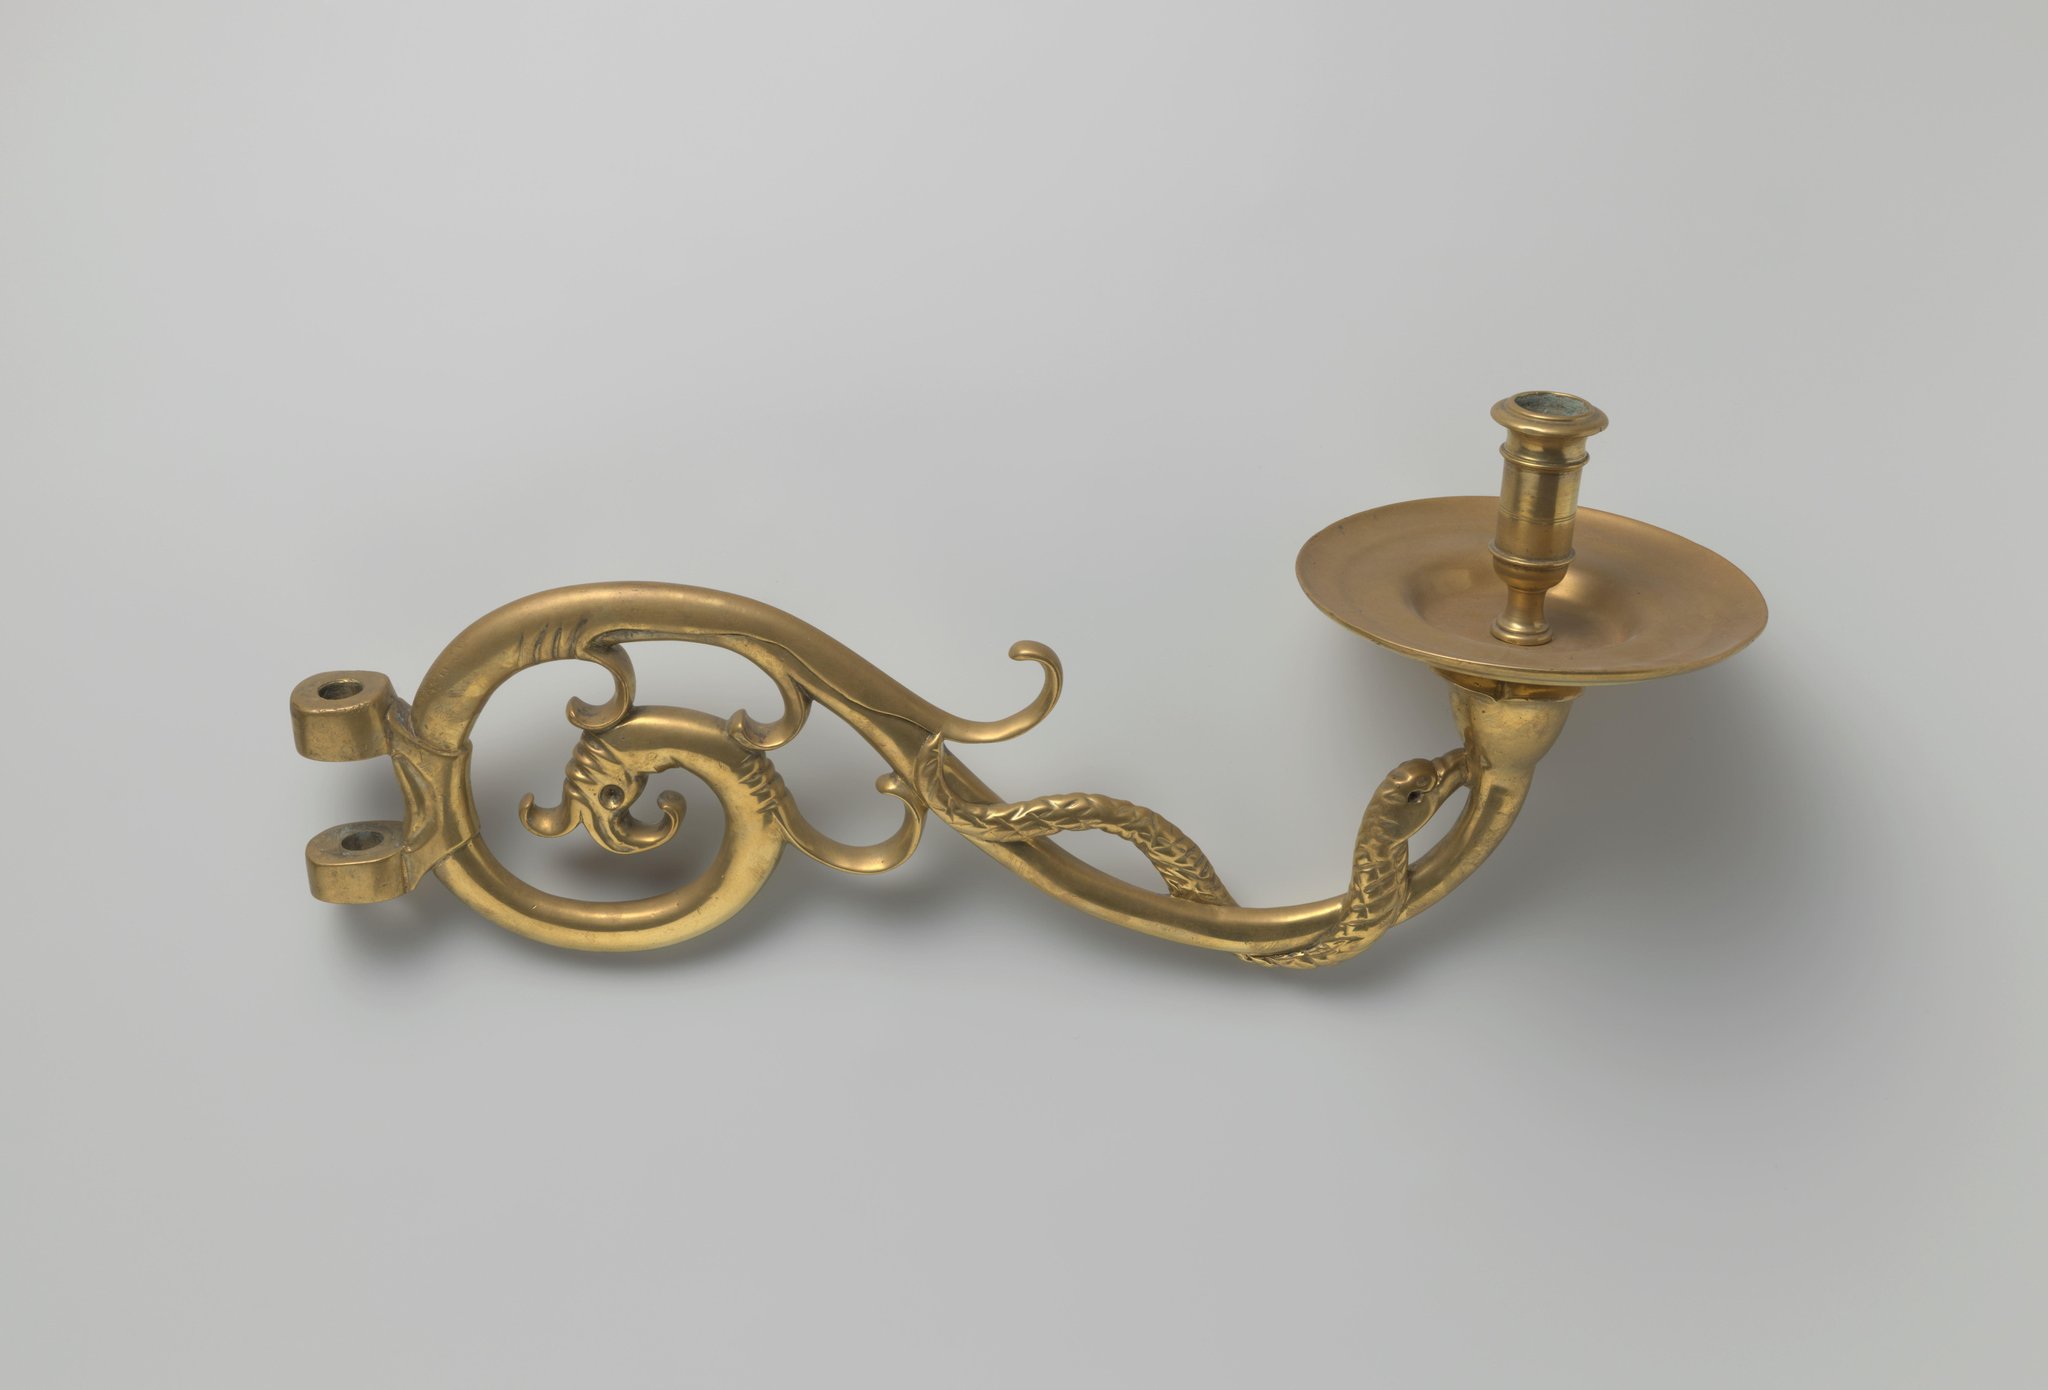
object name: lichtarm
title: Lichtarm met slang en dolfijnenkop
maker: Anonymous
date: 1625-1675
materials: brass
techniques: casting, screwed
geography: netherlands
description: Het voorwerp is in drie delen gegoten: de arm, de vetvanger, de kaarsenhouder. De arm heeft de vorm van een liggende S. Bij het gedeelte, waar de twee ogen zijn aangebracht ter bevestiging aan wand of kansel eindigt hij in een dolfijnenkop. Het gedeelte, waarin de kaarsenhouder op de vetvanger is geschroefd, heeft de vorm van een vierbladige knop. De arm is versierd met in kwabstijl uitgevoerde krullen en met een zich om de arm kronkelende slang. De pin, waarop de arm gestoken moet worden, ontbreekt. De vetvanger is doorboord ten behoeve van electrische bedrading.